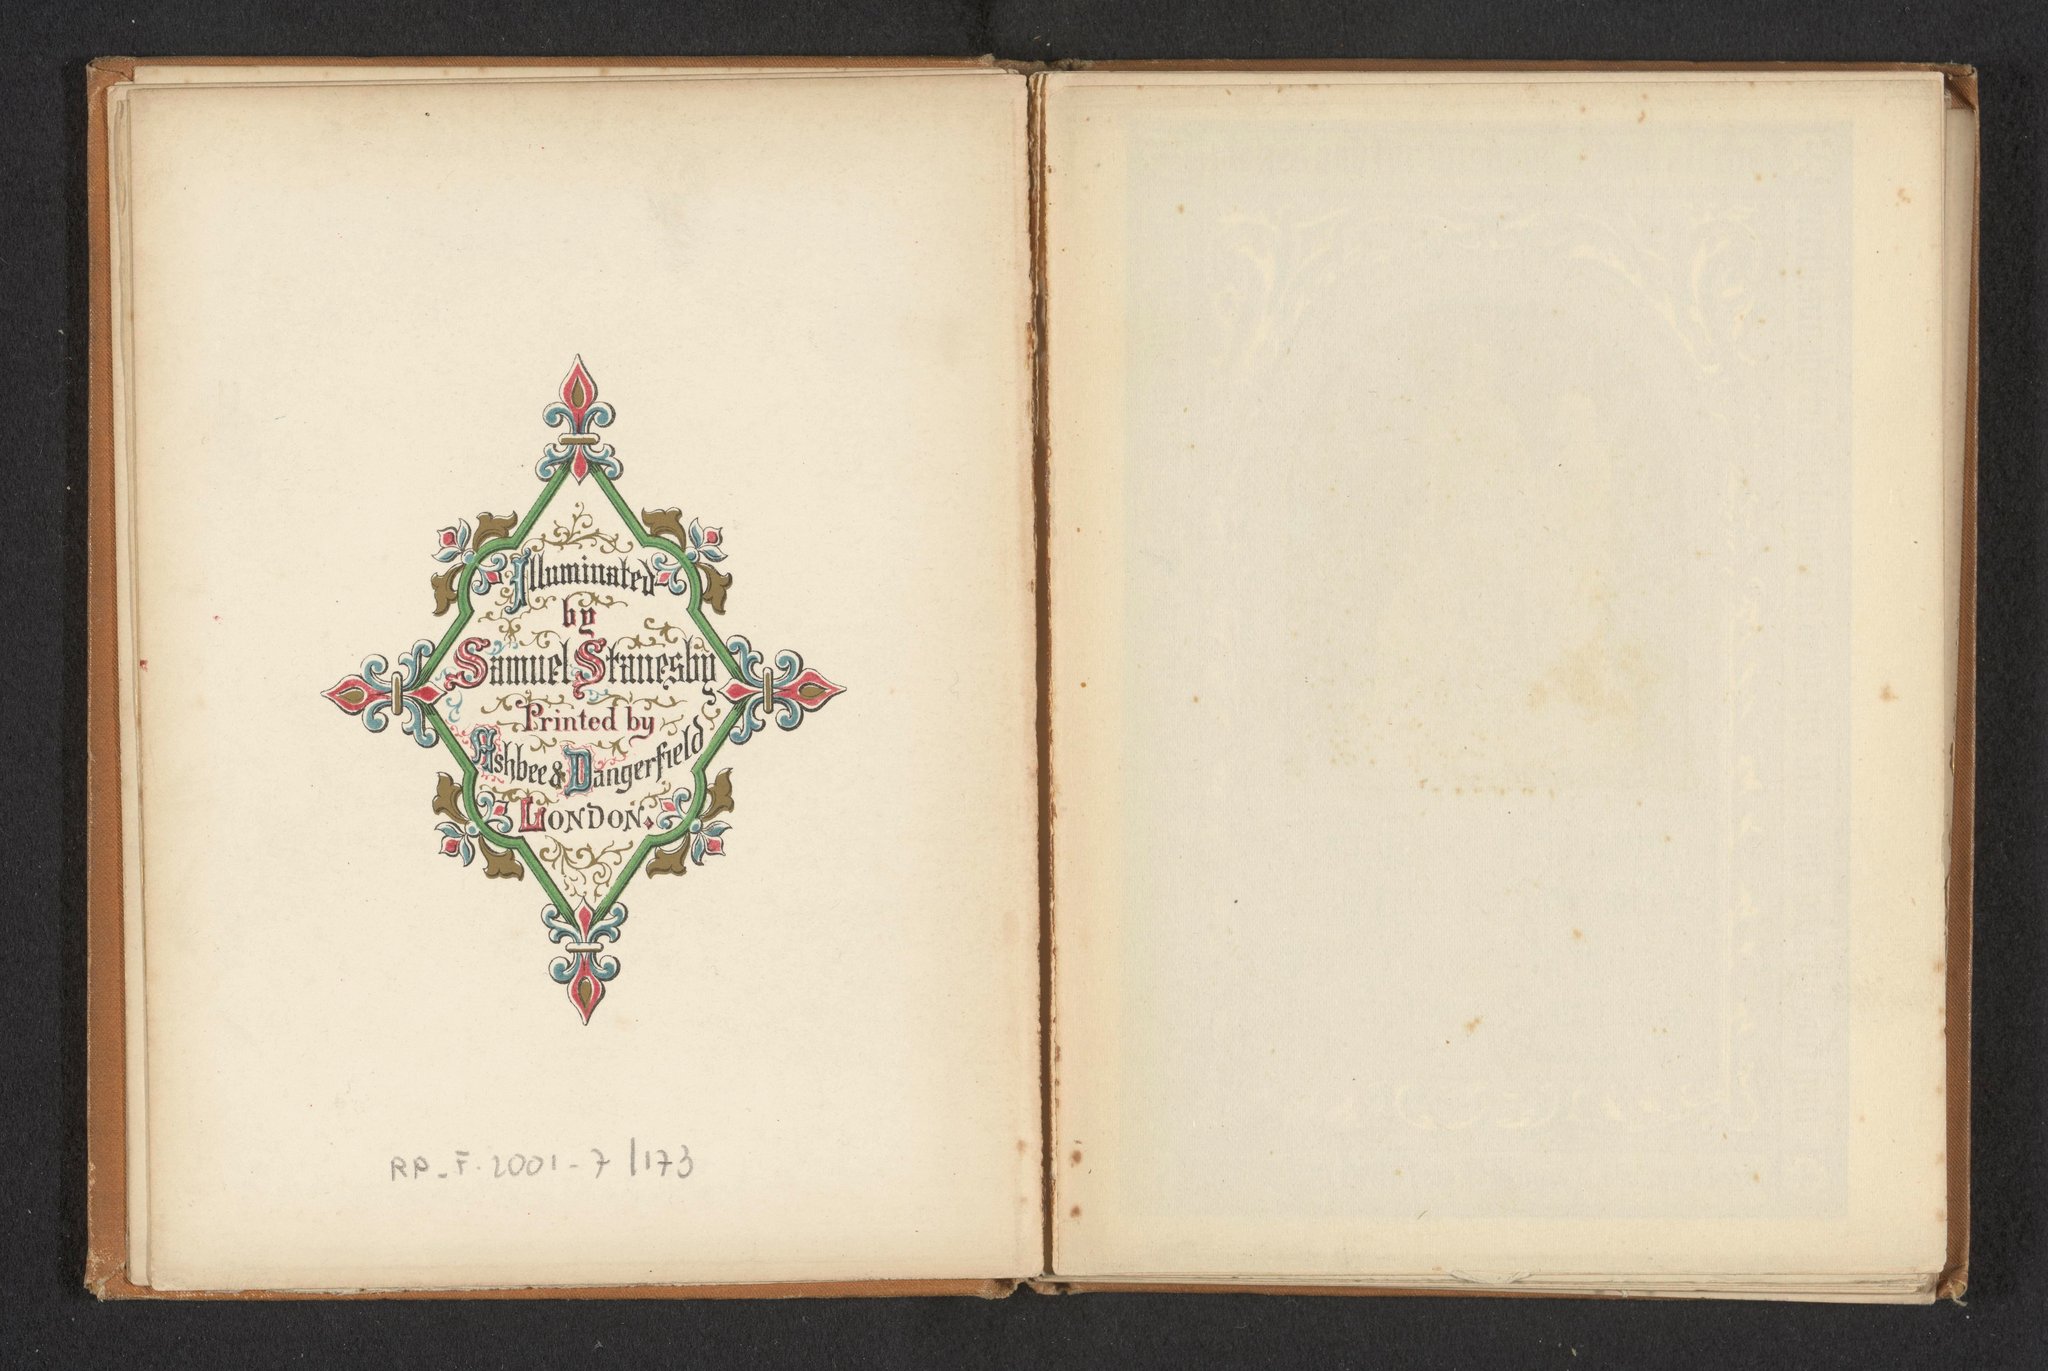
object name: book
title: The wisdom of Solomon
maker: samuel stanesby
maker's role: illustrator, kalligraaf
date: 1861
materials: cardboard, linen, paper, photographic support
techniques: albumen print, chromolithography, printing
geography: london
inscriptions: inscription: ‘To S. Herbert Mappie Benton with Uncle Bernard's & At. Susan's best love April 25, 1882. Newark-on-Trent’